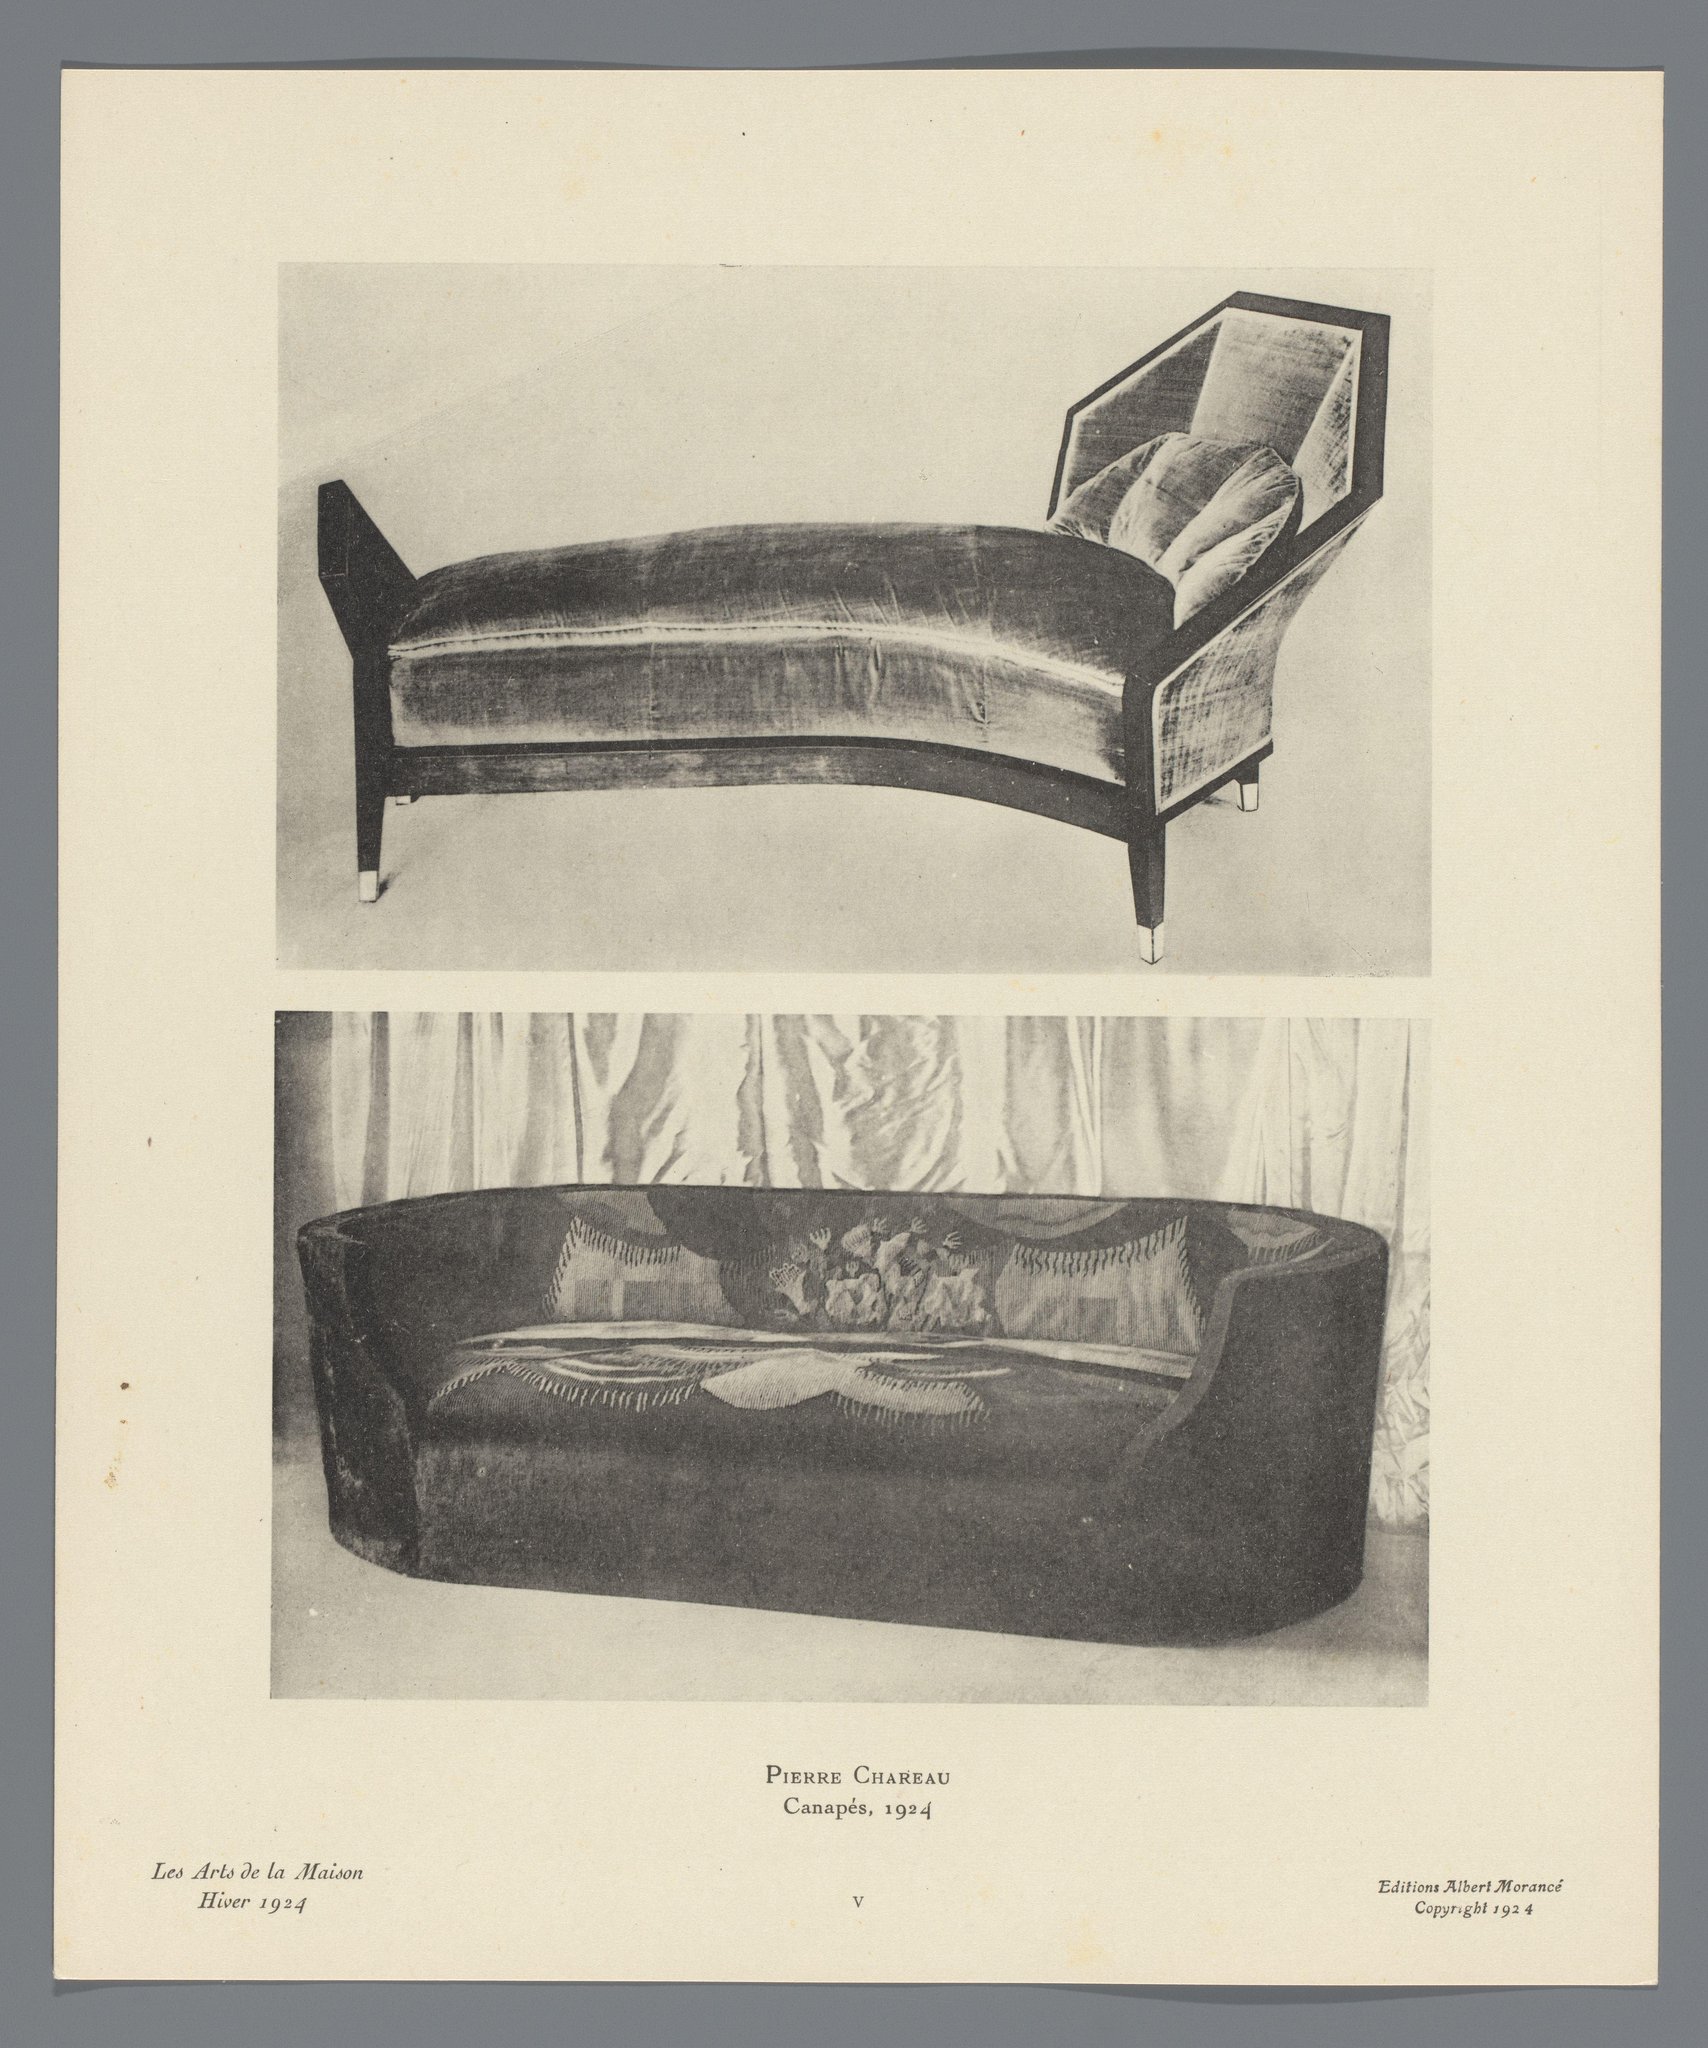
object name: photograph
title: Pierre Chareau. Canapés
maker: Anonymous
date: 1924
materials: paper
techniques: photograph, lithograph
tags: france